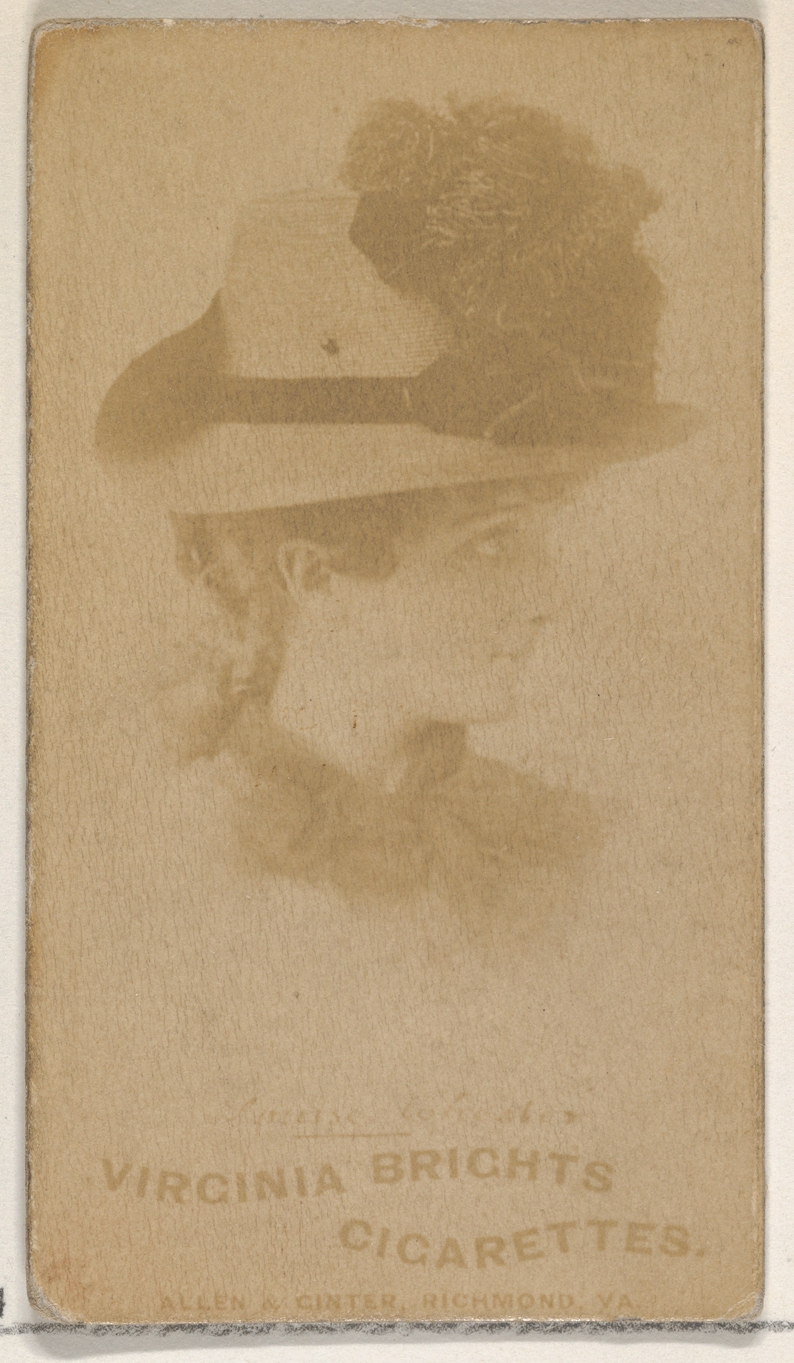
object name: photograph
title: From the Actors and Actresses series (N45, Type 5) for Virginia Brights Cigarettes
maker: allen & ginter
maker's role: publisher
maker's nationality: american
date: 1888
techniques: albumen silver print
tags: women,actresses